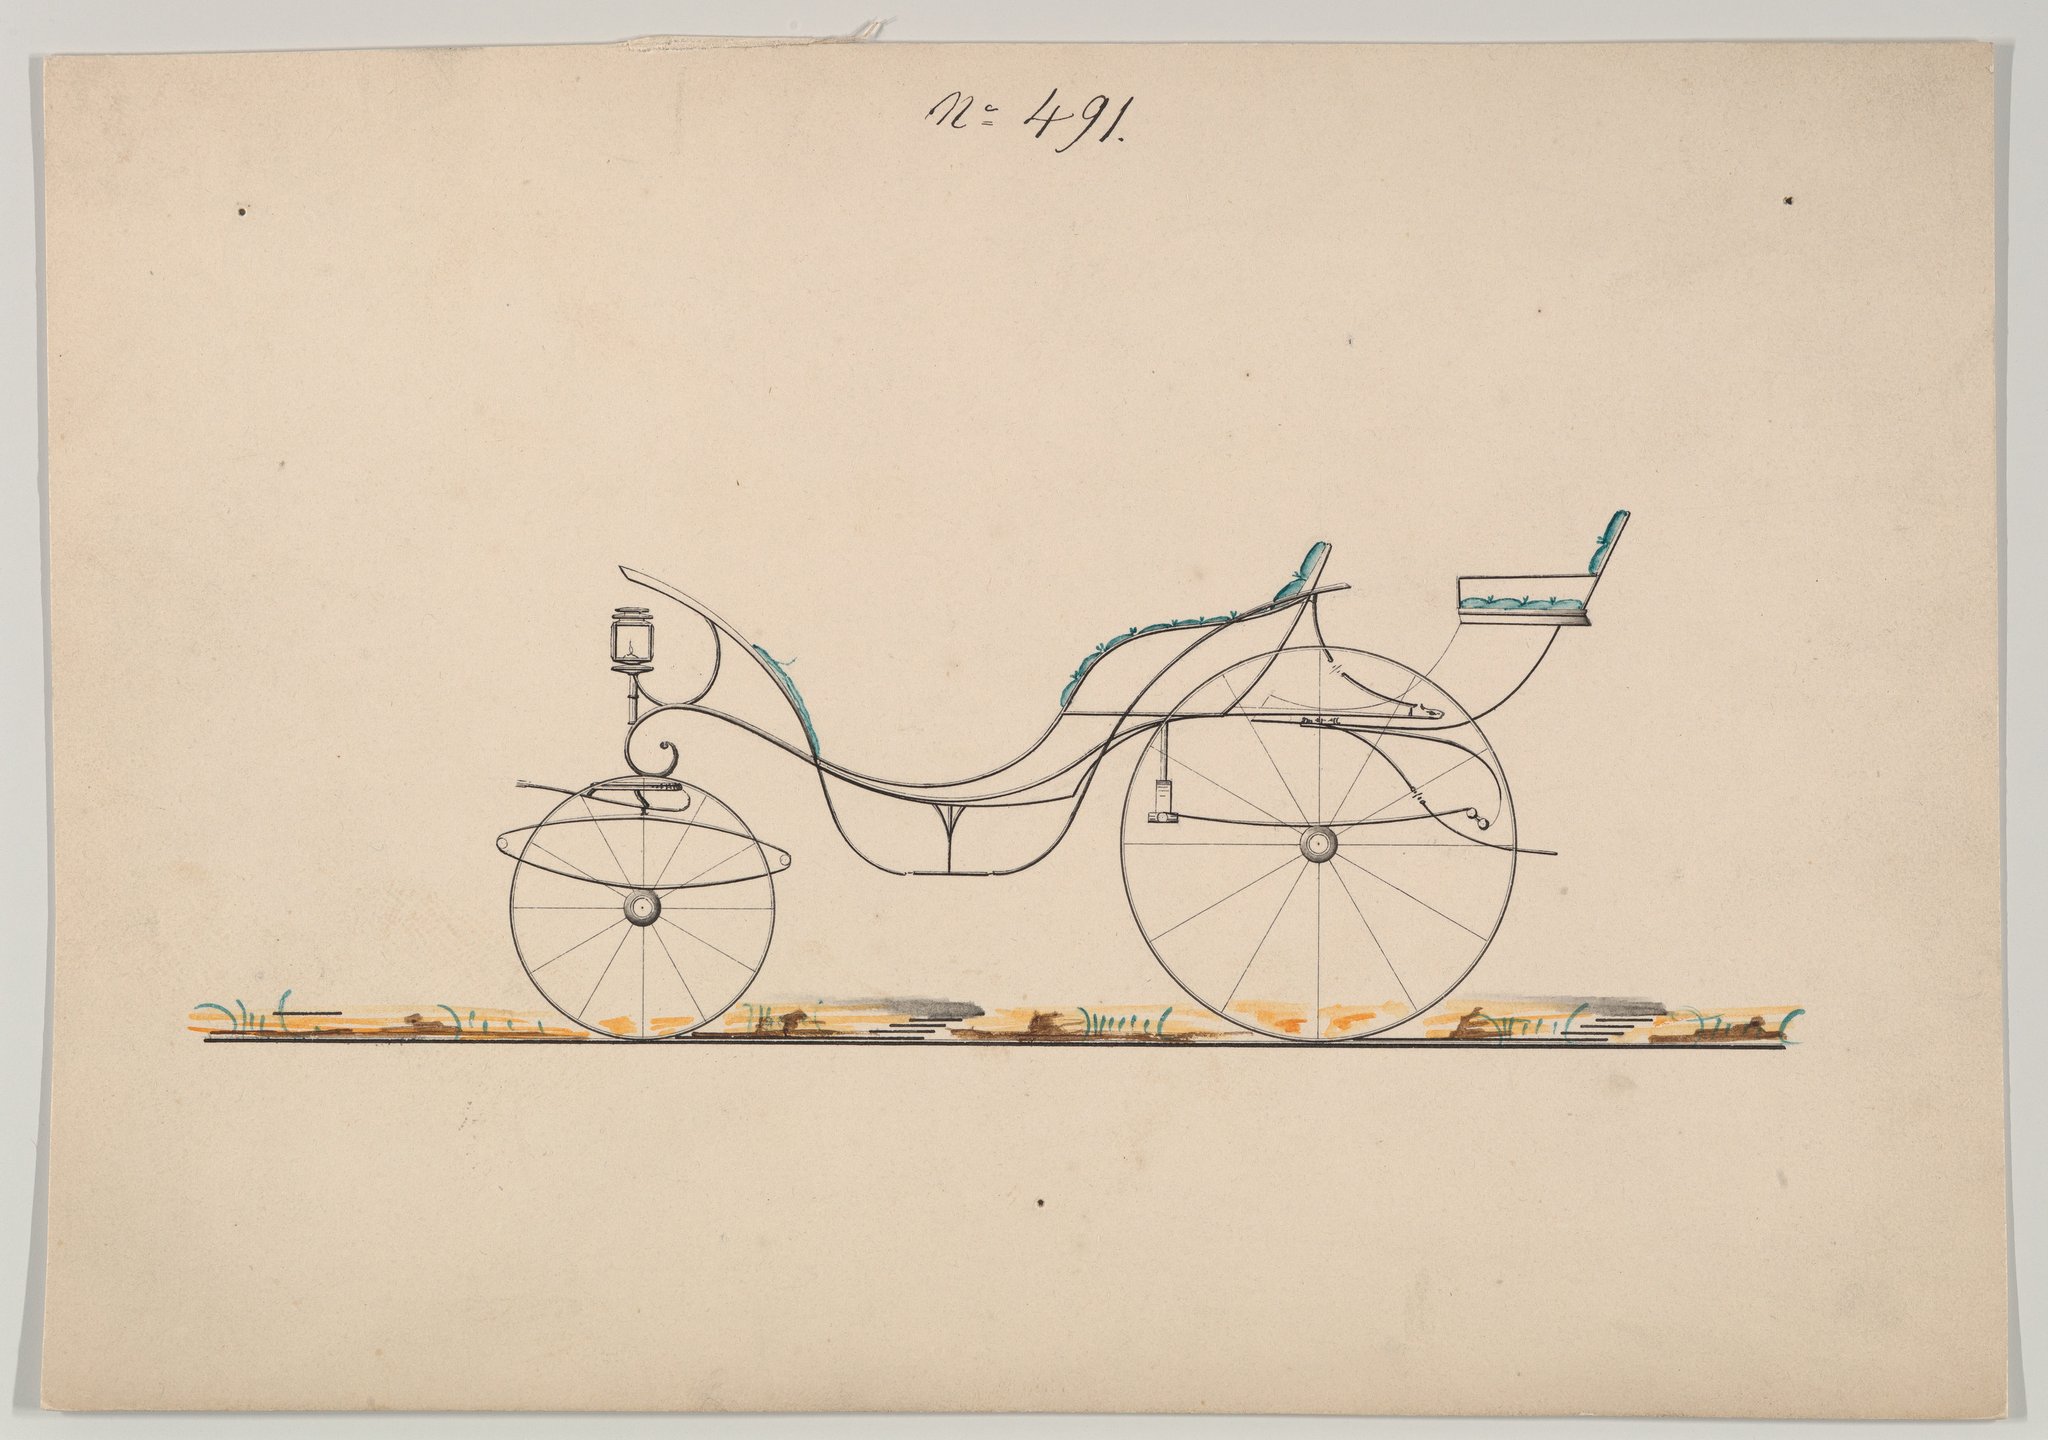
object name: drawing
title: Phaeton #491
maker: brewster & co.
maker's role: manufacturer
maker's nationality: american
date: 1865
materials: ink, watercolor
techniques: pen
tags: carriages